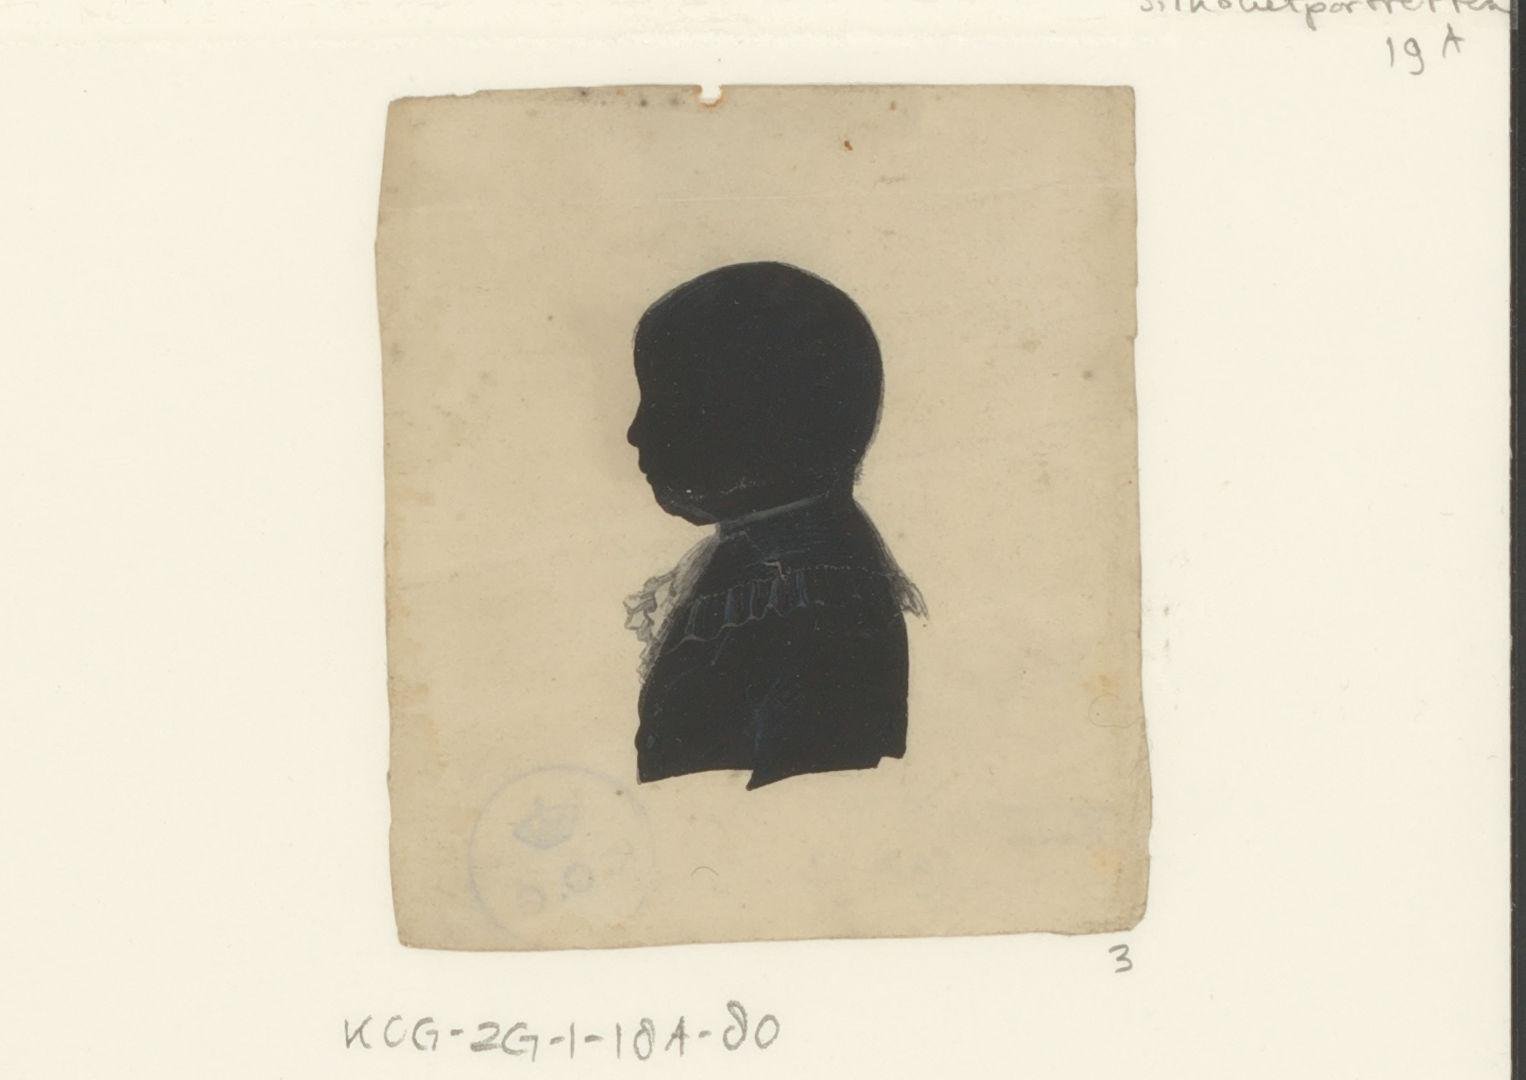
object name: drawing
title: Silhouetportret van een onbekende jongen met kraag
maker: Anonymous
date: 1775-1849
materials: paint, paper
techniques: brush, pen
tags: boy (child between toddler and youth), neck-gear: collar, historical persons not known by name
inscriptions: collector's mark: Lugt 1641a, stamp, collector's mark: Lugt 1641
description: Silhouetportret van een onbekende jongen met een platte kraag met een geplooide rand. Onderwerpsrubrieken binnen de Atlas Zeden en Gewoonten: Schoone kunsten, Silhouetportretten.